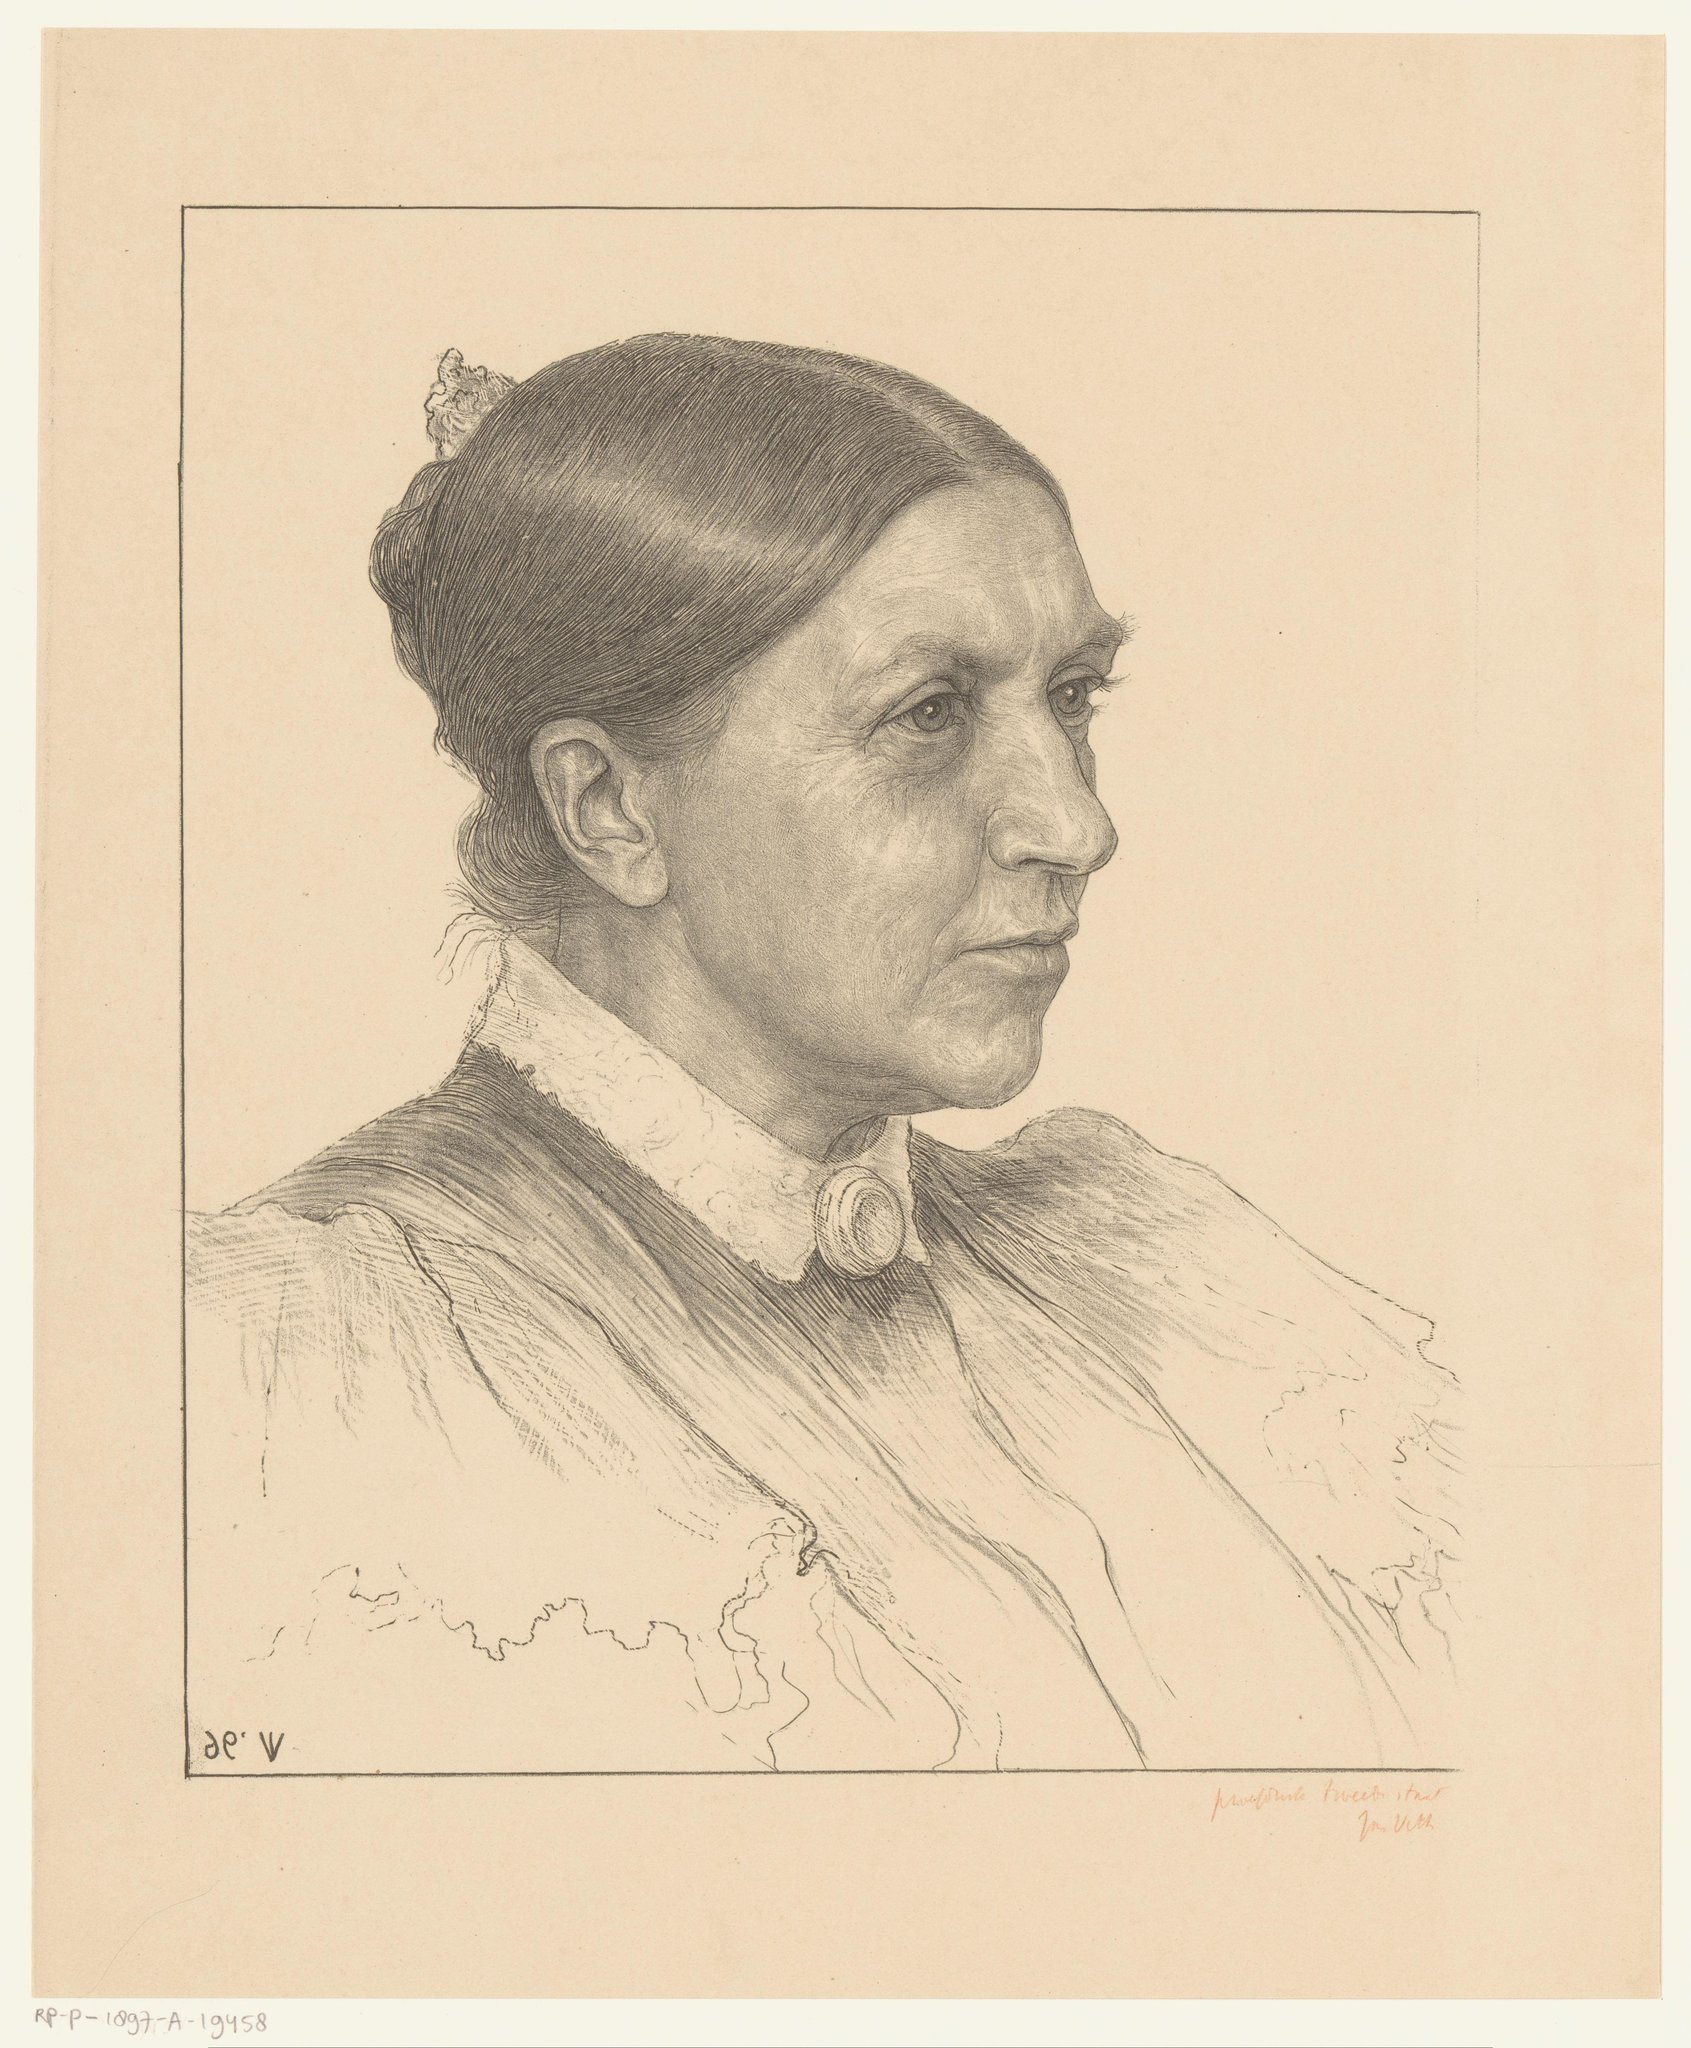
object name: print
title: Portret van Jeltje de Bosch Kemper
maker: jan veth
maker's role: designer, draughtsman, painter, print maker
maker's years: 1864-1925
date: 1896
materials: paper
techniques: lithograph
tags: amsterdam, historical persons - bb - woman (+ (full) bust portrait)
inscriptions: inscription: Lugt 2228, inscription: ‘Proefdruk tweede staat / Jan Veth’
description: Deze prent werd uitgegeven door De Amsterdammer op 8 november 1896.